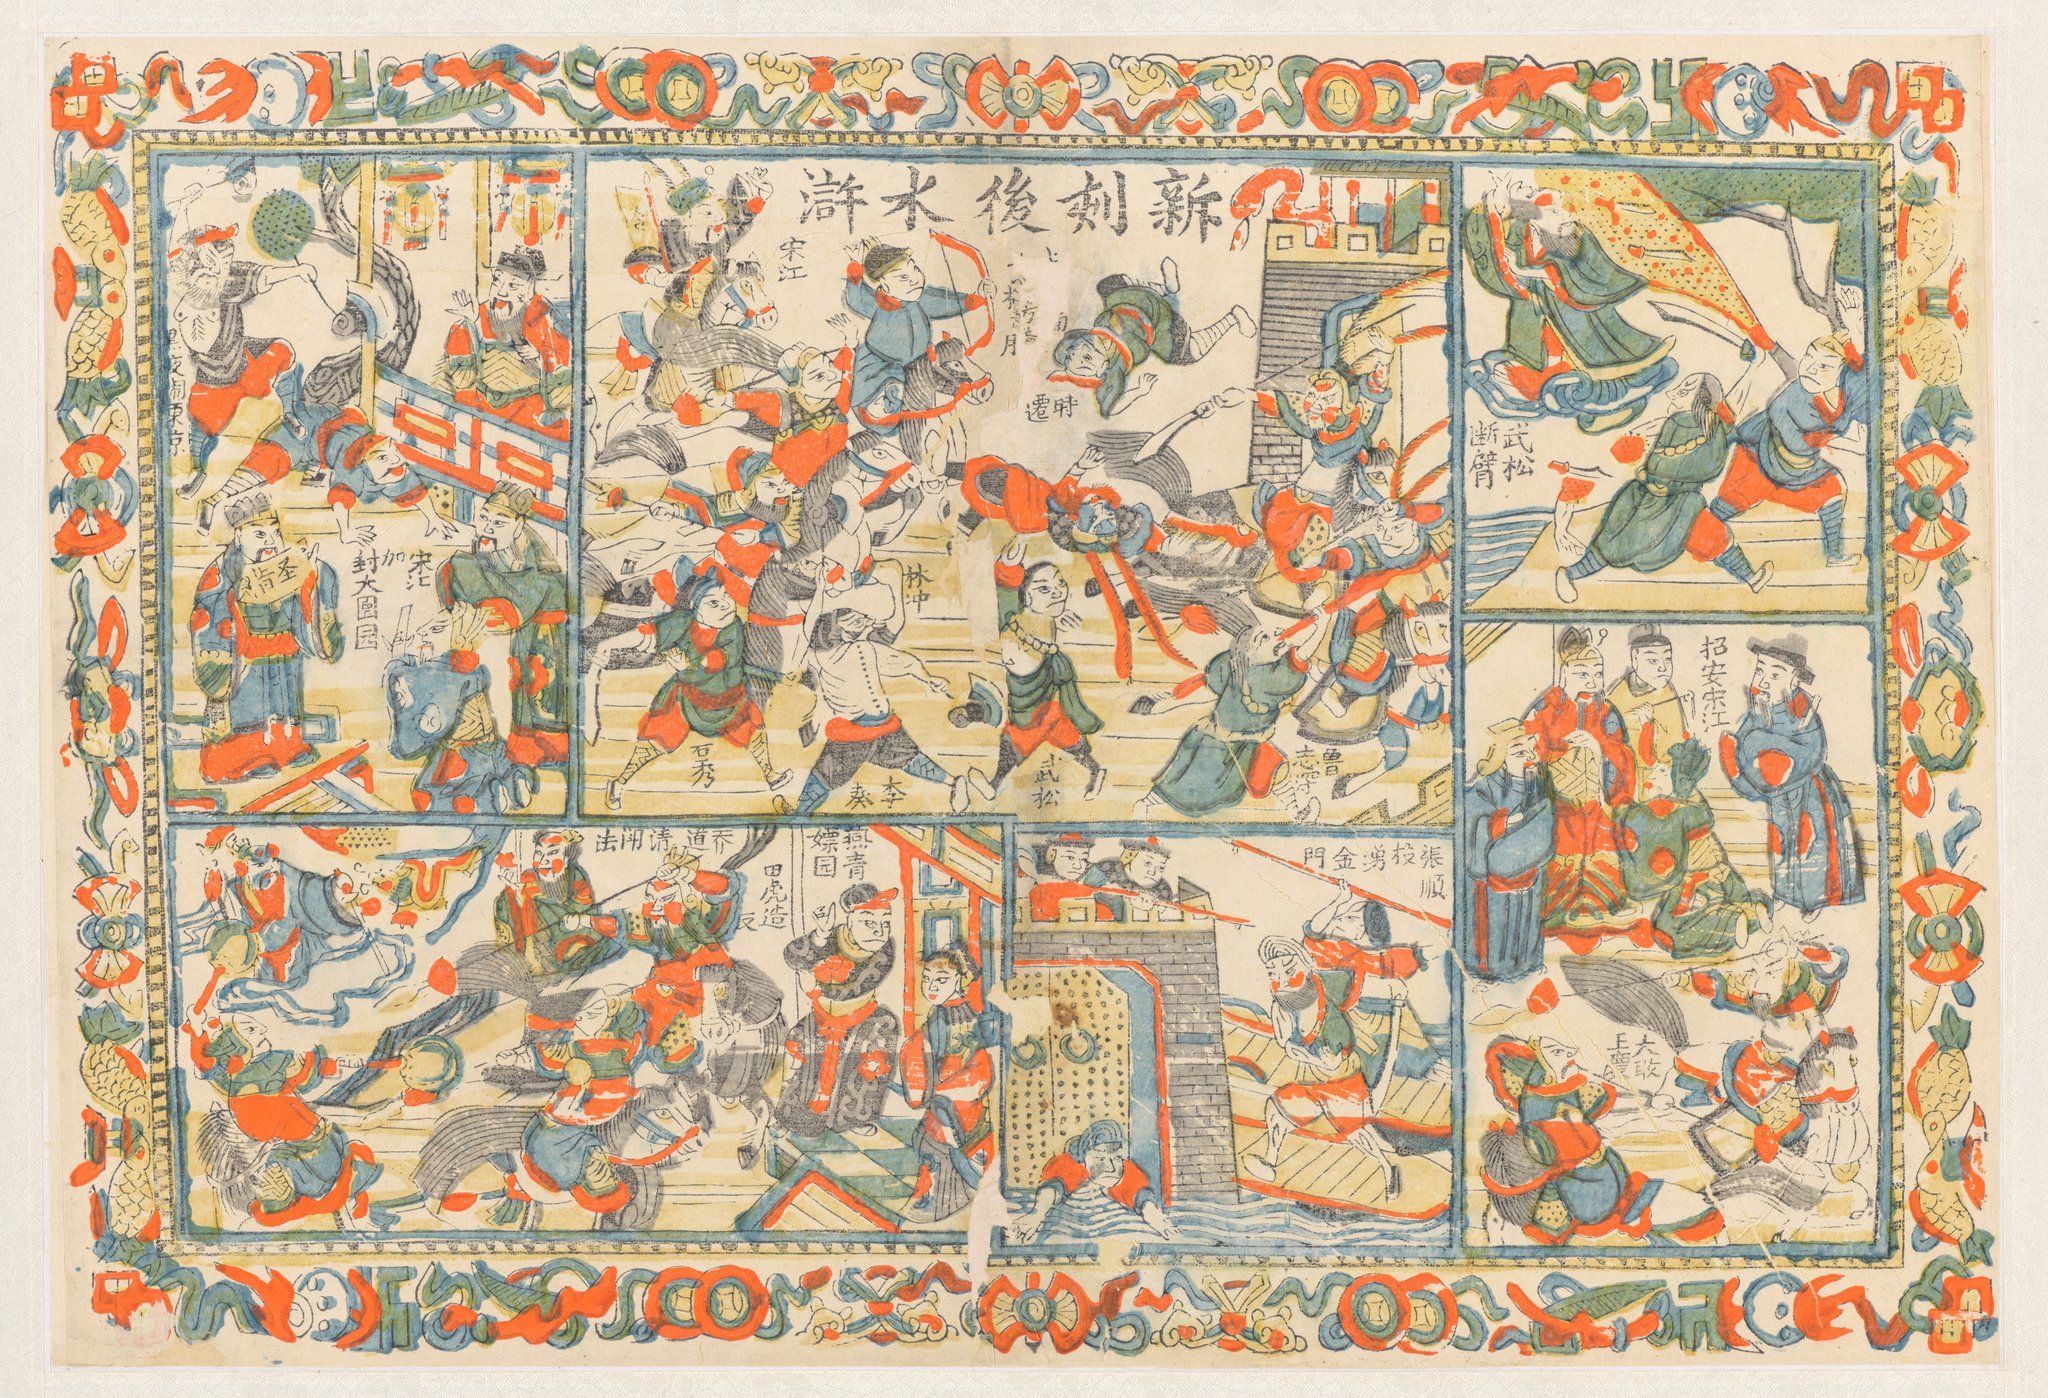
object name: print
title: A Newly-Cut Print : Scenes from the Second Part of Outlaws of the Marsh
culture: chinese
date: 1796-1820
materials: ink, paper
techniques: hand coloring, woodblock print